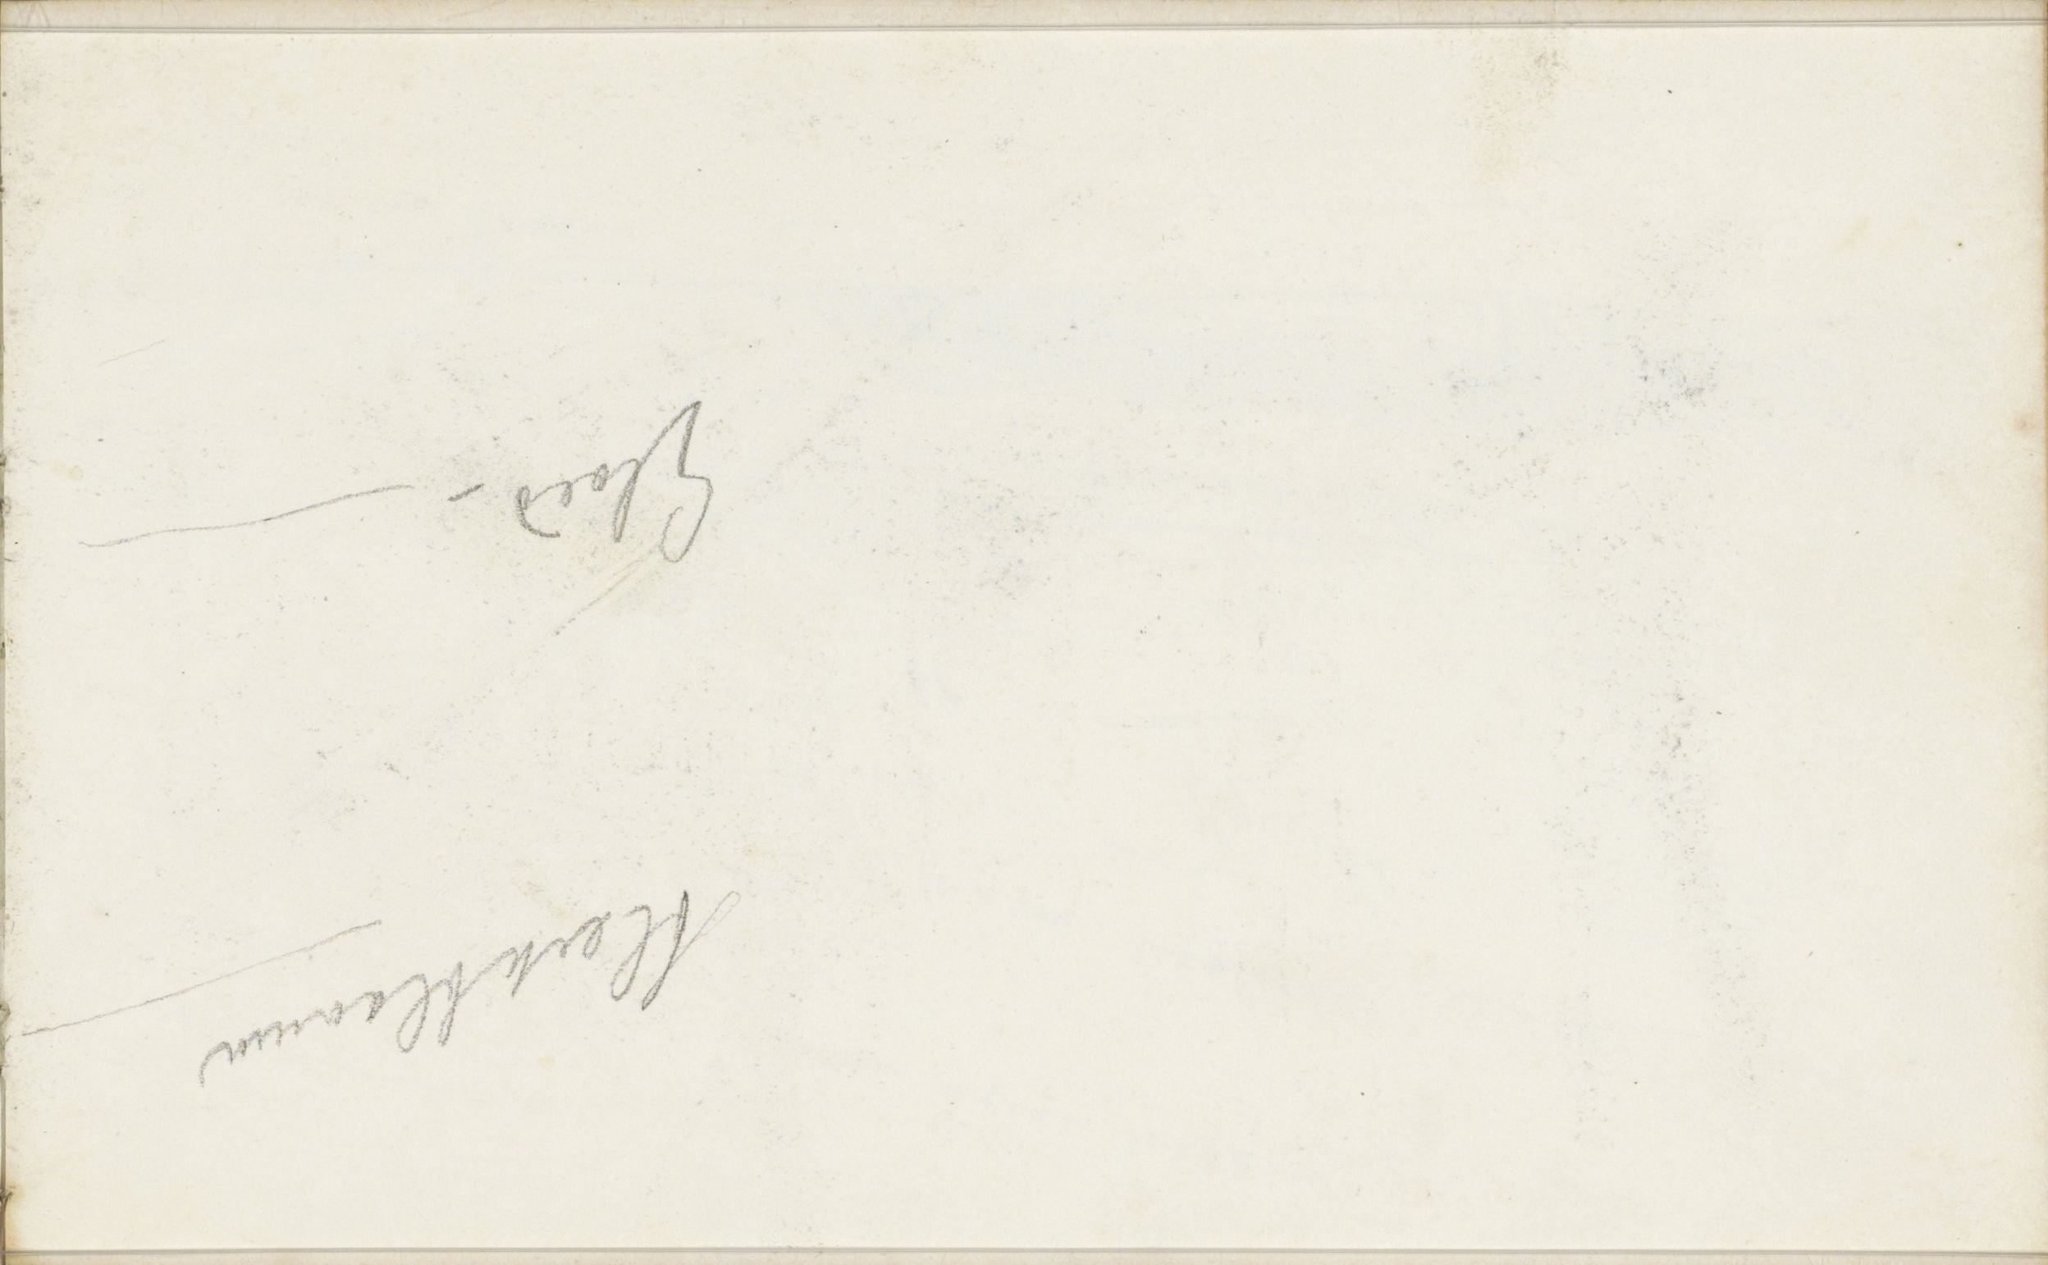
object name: sketchbook leaf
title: Kleurnotities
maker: johannes tavenraat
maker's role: draughtsman, painter, print maker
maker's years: 1809-1881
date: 1840-1841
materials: paper, pencil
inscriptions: kleurnotitie, handgeschreven: de notities verwijzen naar de schets op pagina 37 verso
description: Blad 38 recto uit een schetsboek met 41 bladen.